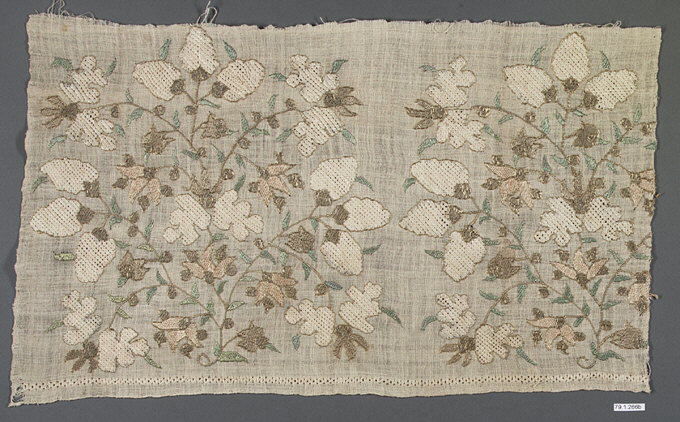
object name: towel end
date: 1801-1833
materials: linen, metal thread, silk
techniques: embroidery, weave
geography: turkey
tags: flowers